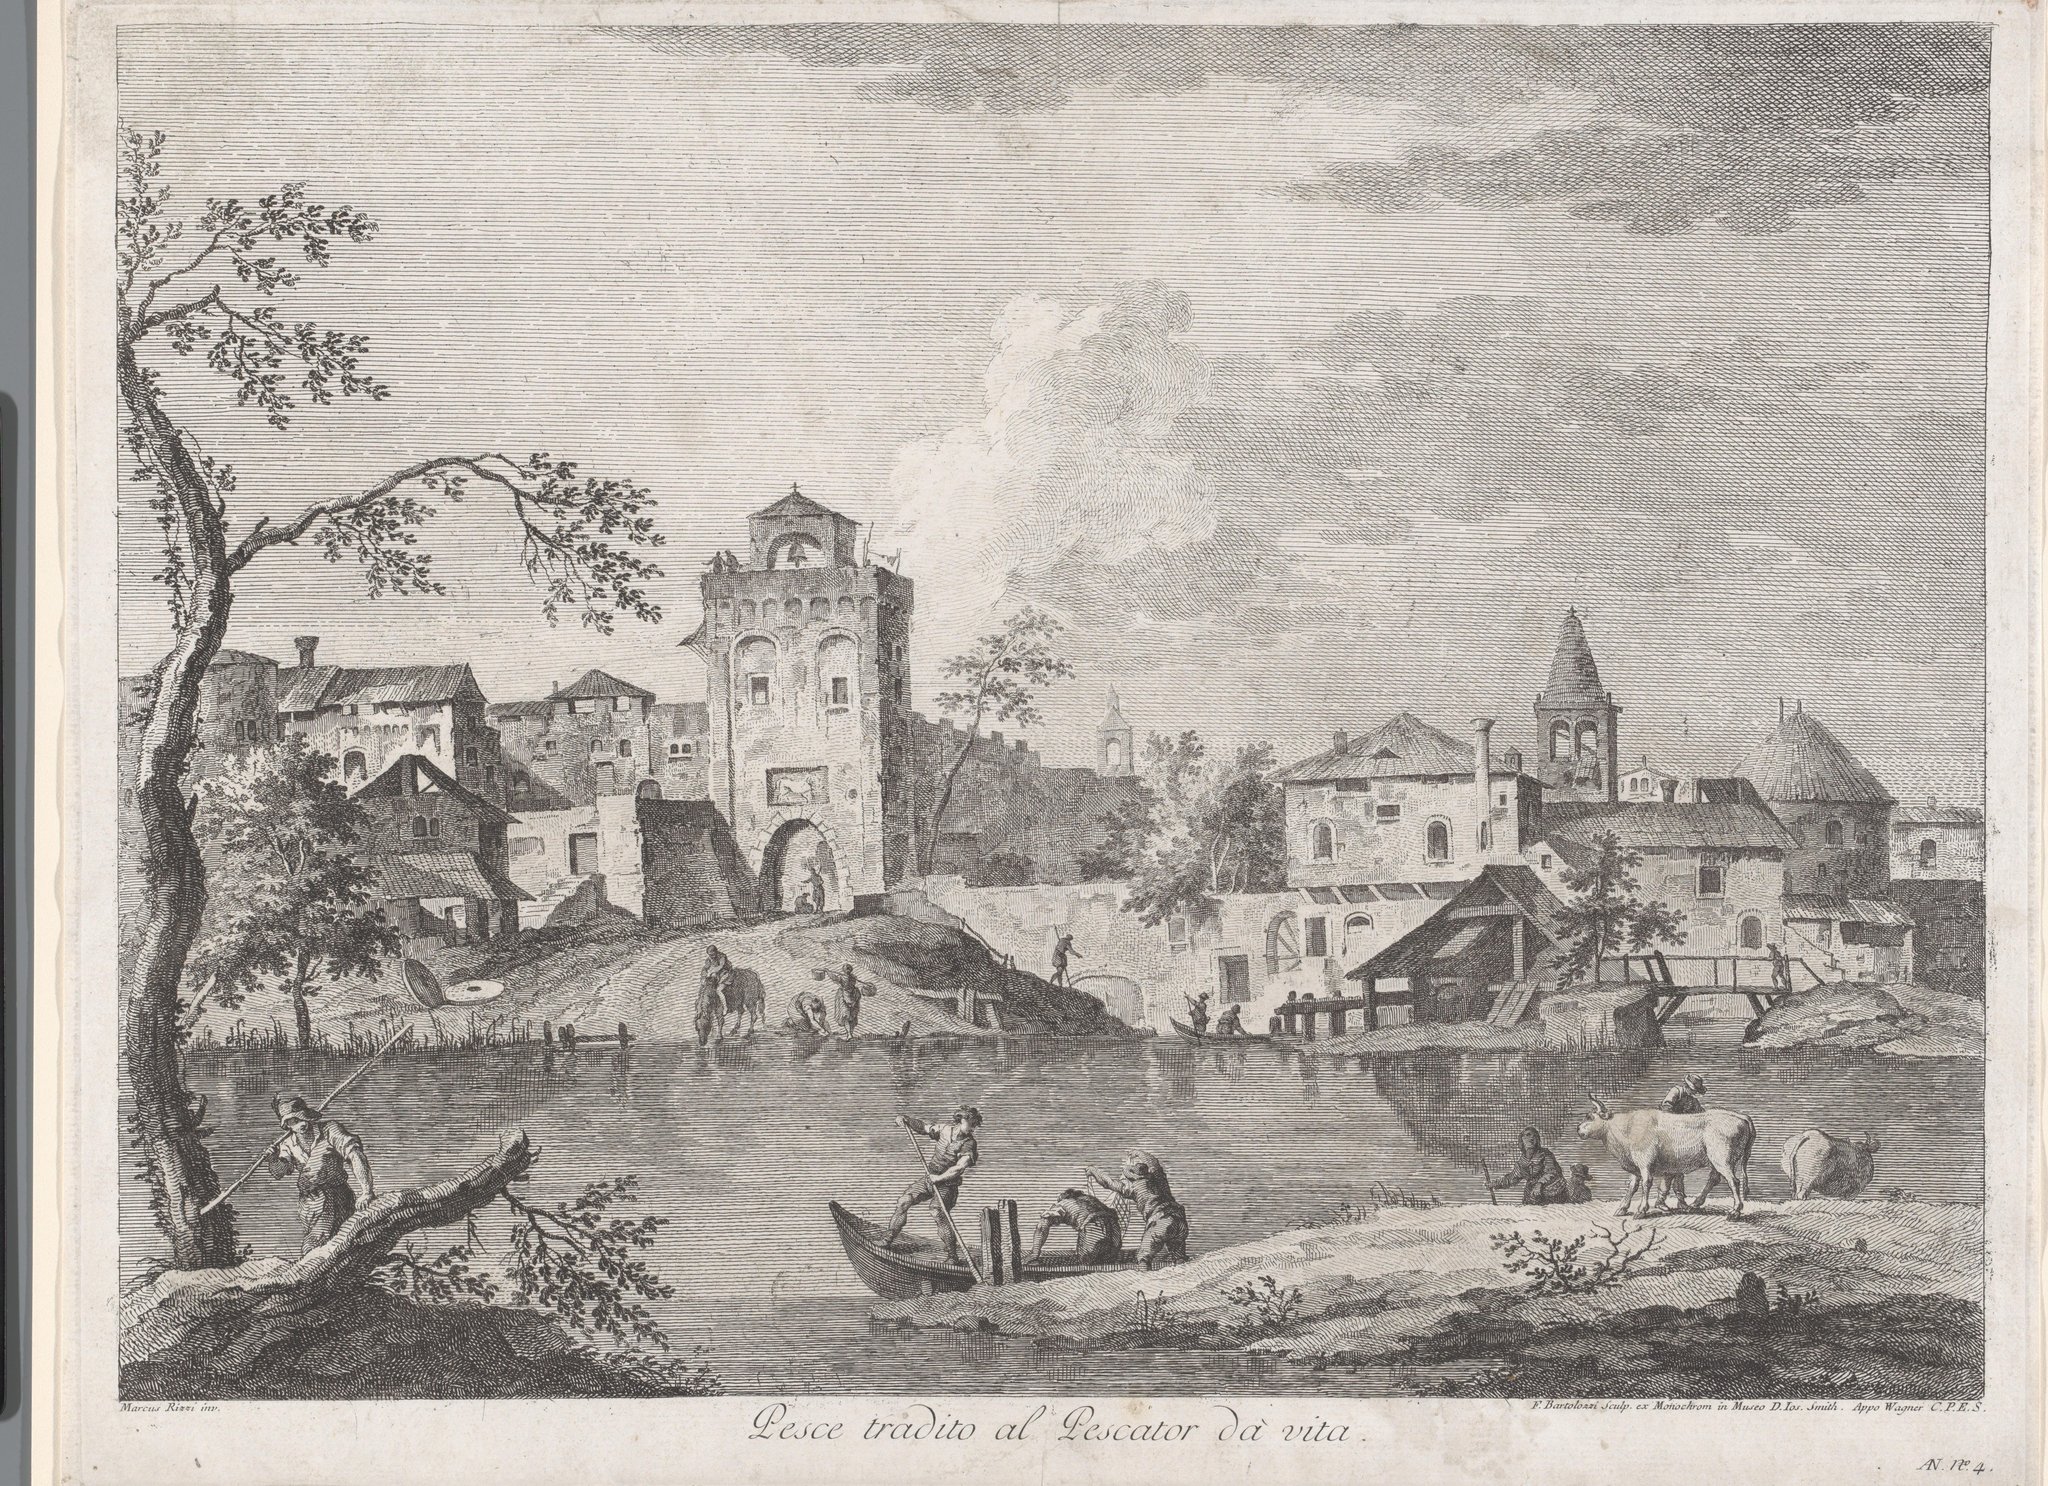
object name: print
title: Pesce tradito al pescator dà vita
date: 1739-1780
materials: paper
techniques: engraving, etching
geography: venice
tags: city-view, and landscape with man-made constructions, landscapes, fisherman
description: Vissers en boeren aan de oever van een rivier. Op de achtergrond een stad. Italiaanse titel in ondermarge. Genummerd rechtsonder: AN. No. 4.